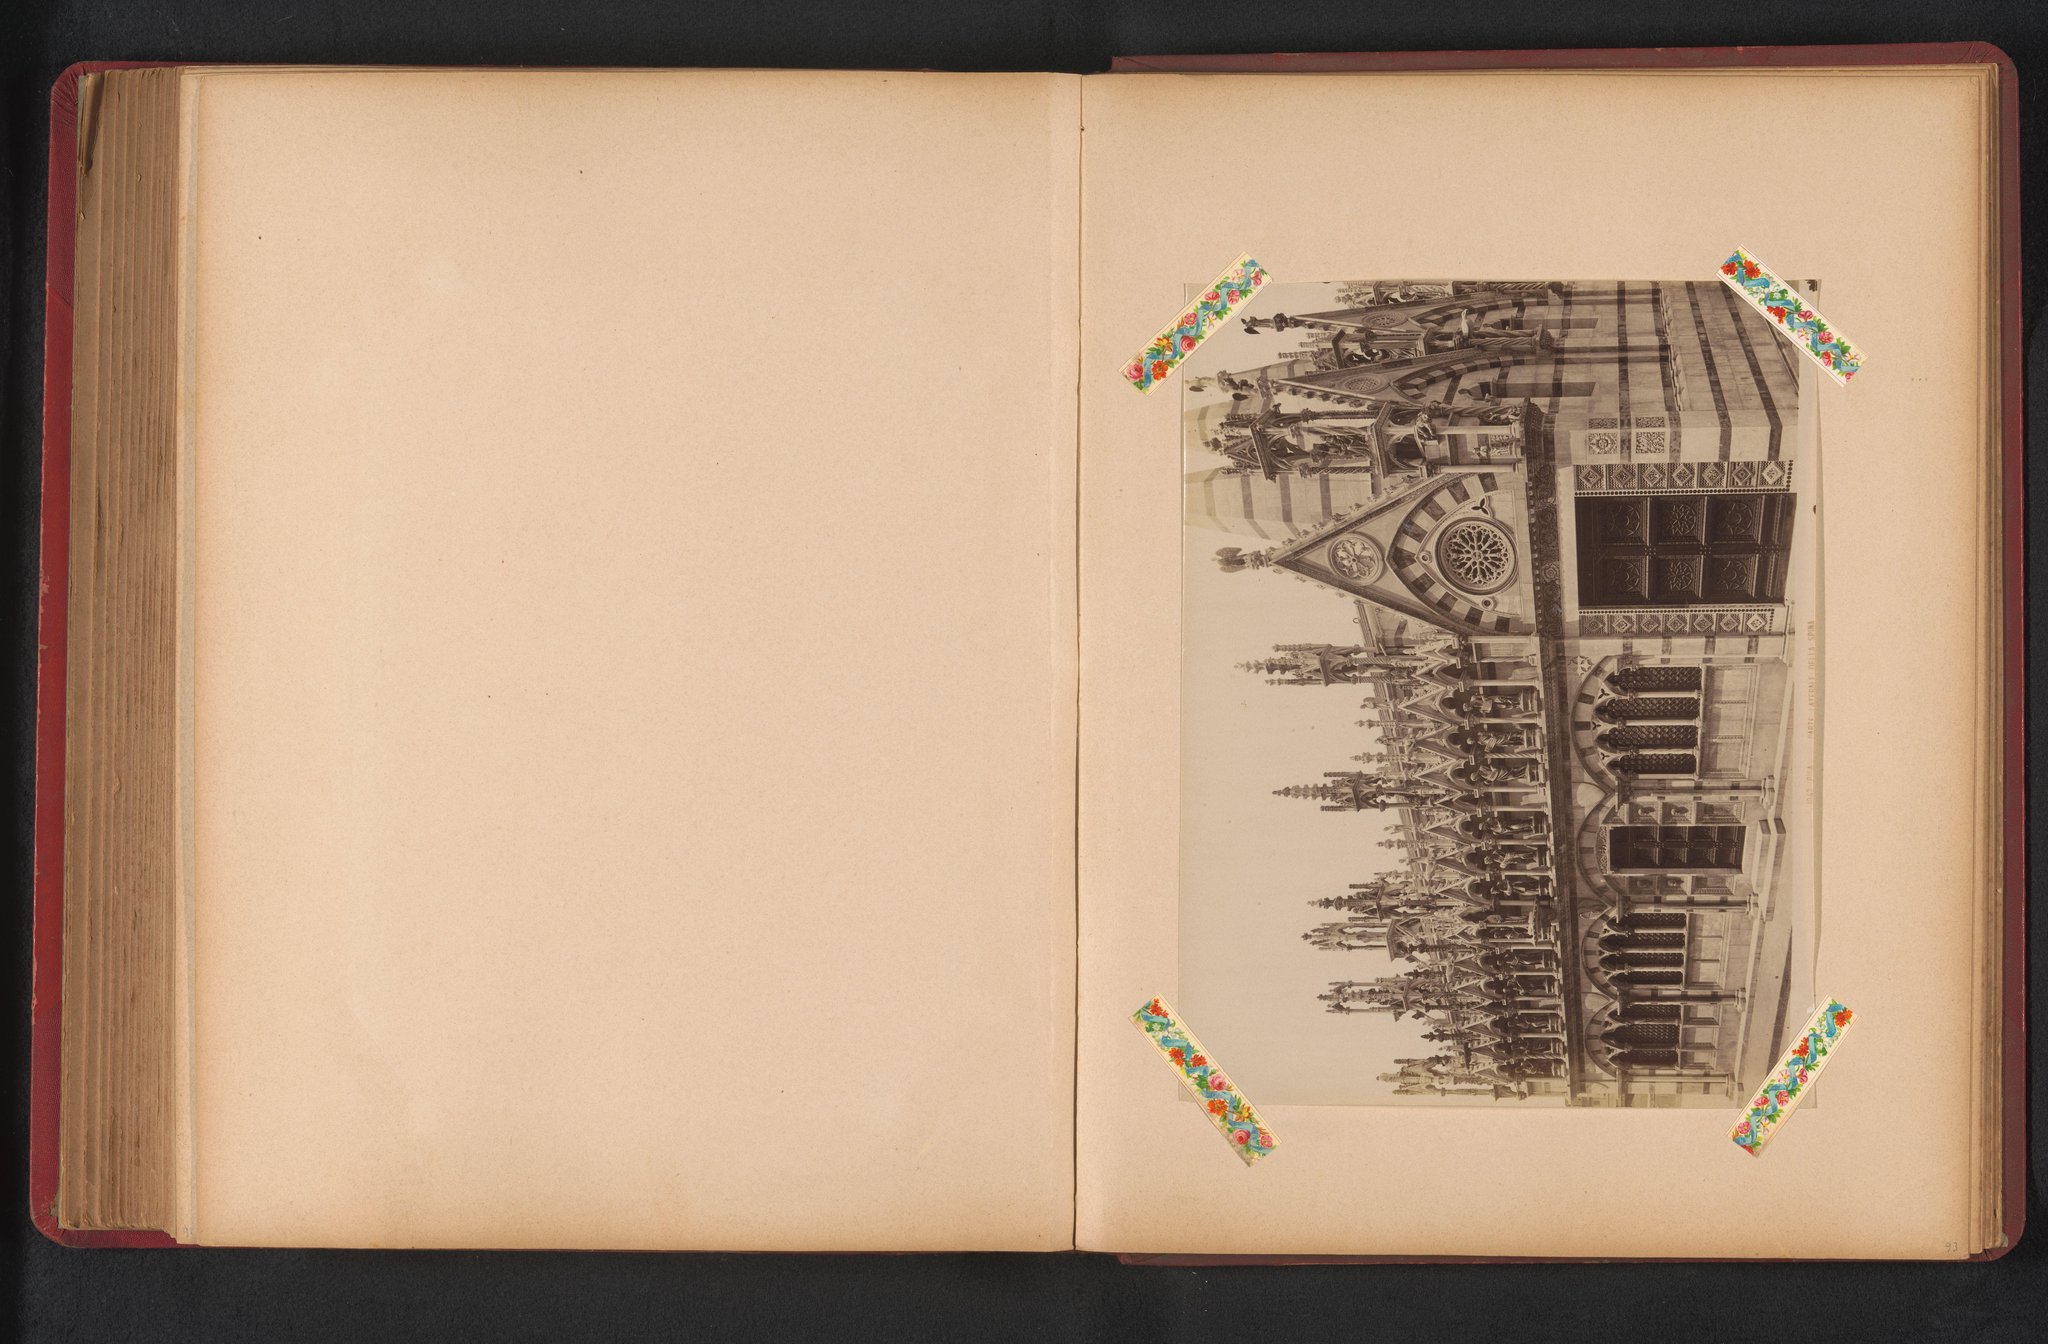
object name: photograph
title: Exterieur van de Santa Maria della Spina in Pisa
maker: Anonymous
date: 1860-1900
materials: photographic support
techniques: albumen print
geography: pisa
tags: church (exterior)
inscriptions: number: ‘1042’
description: Onderdeel van Fotoalbum met opnames van bezienswaardigheden in Italiaanse steden en van kunstwerken.